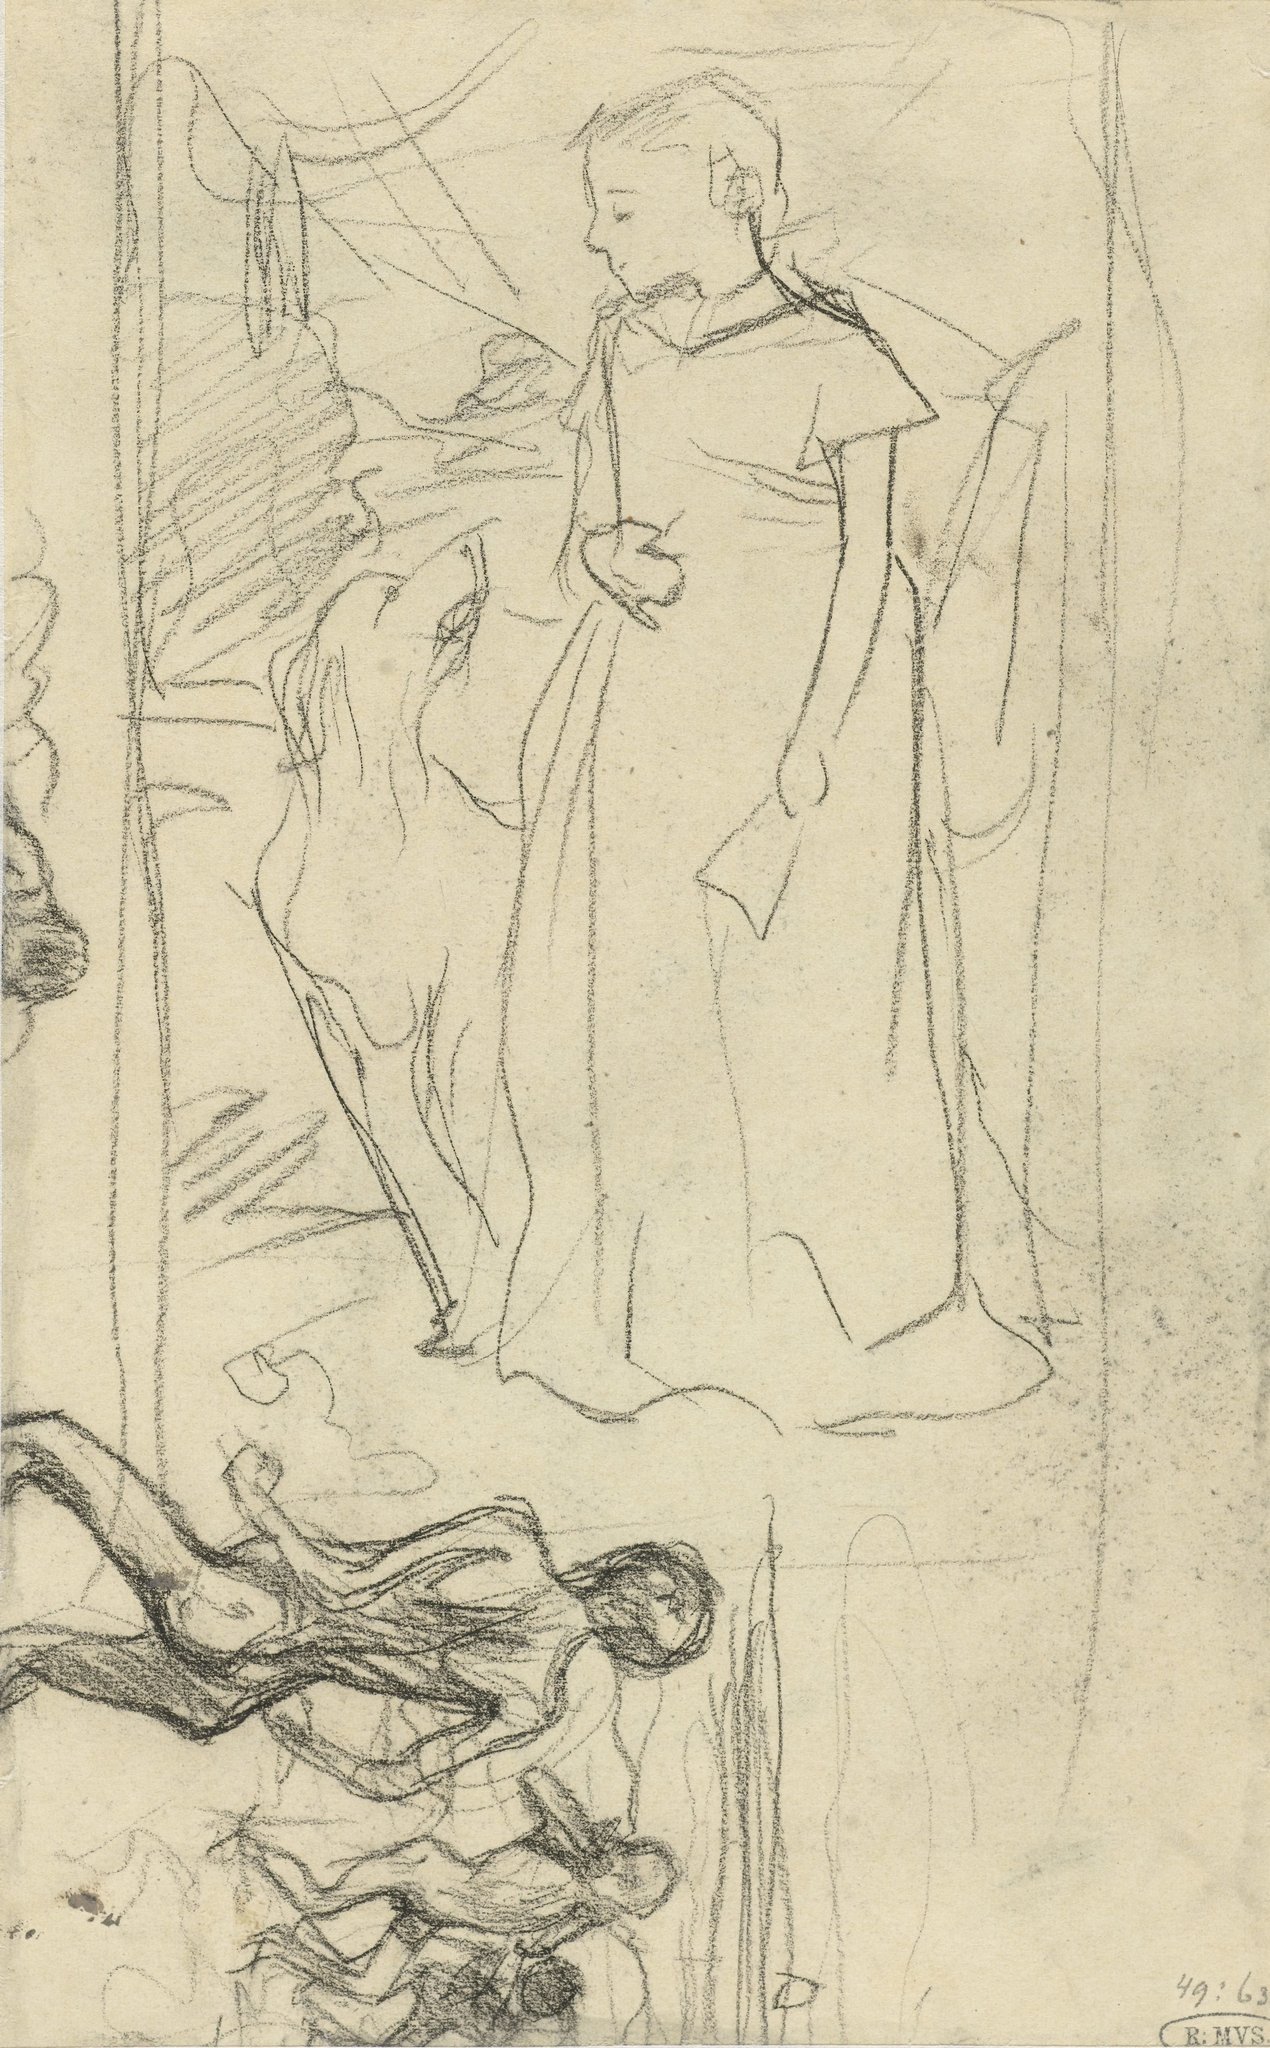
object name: drawing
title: Schetsen van een meisje met hond en badende jongens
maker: marius bauer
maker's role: draughtsman, print maker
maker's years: 1867-1932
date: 1877-1932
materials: chalk, paper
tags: dog